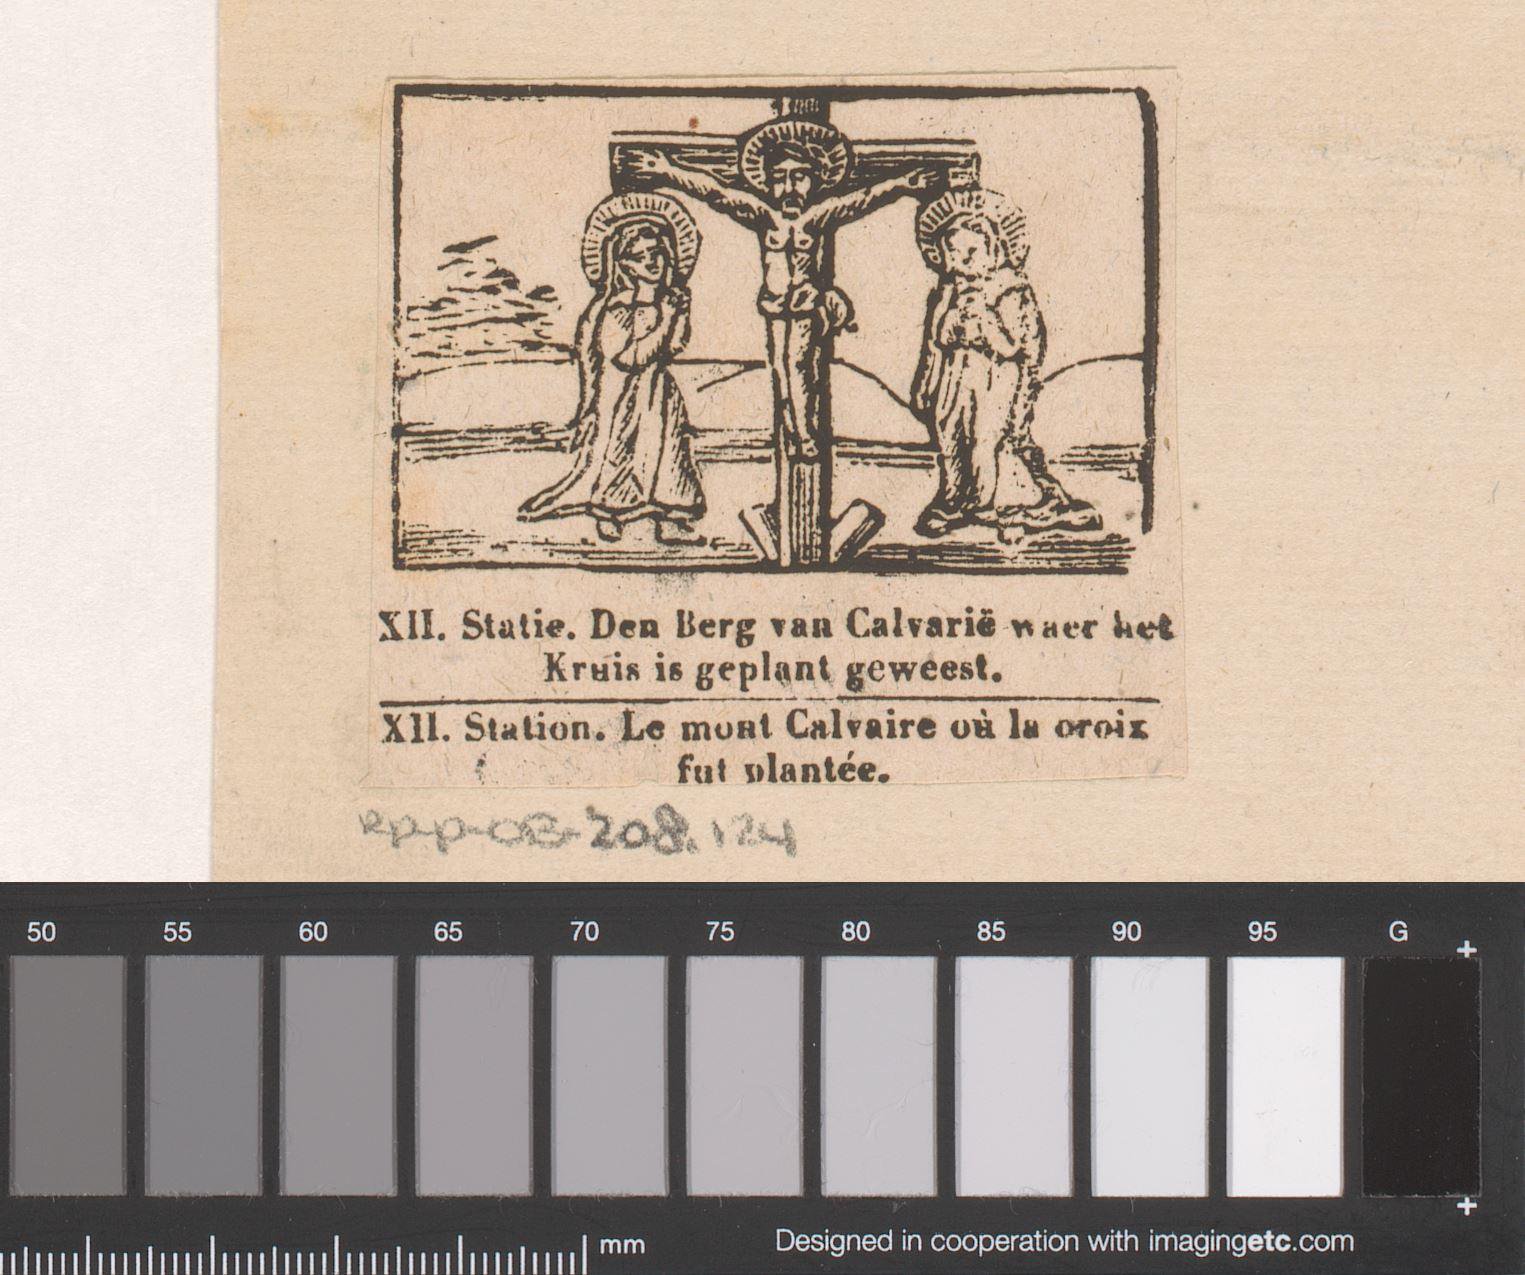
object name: print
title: Kruiswegstaties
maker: Anonymous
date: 1600-1699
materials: paper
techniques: letterpress printing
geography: netherlands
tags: the 14 franciscan stations of the cross (12), crucified christ with mary and john on either side of the cross; holy rood